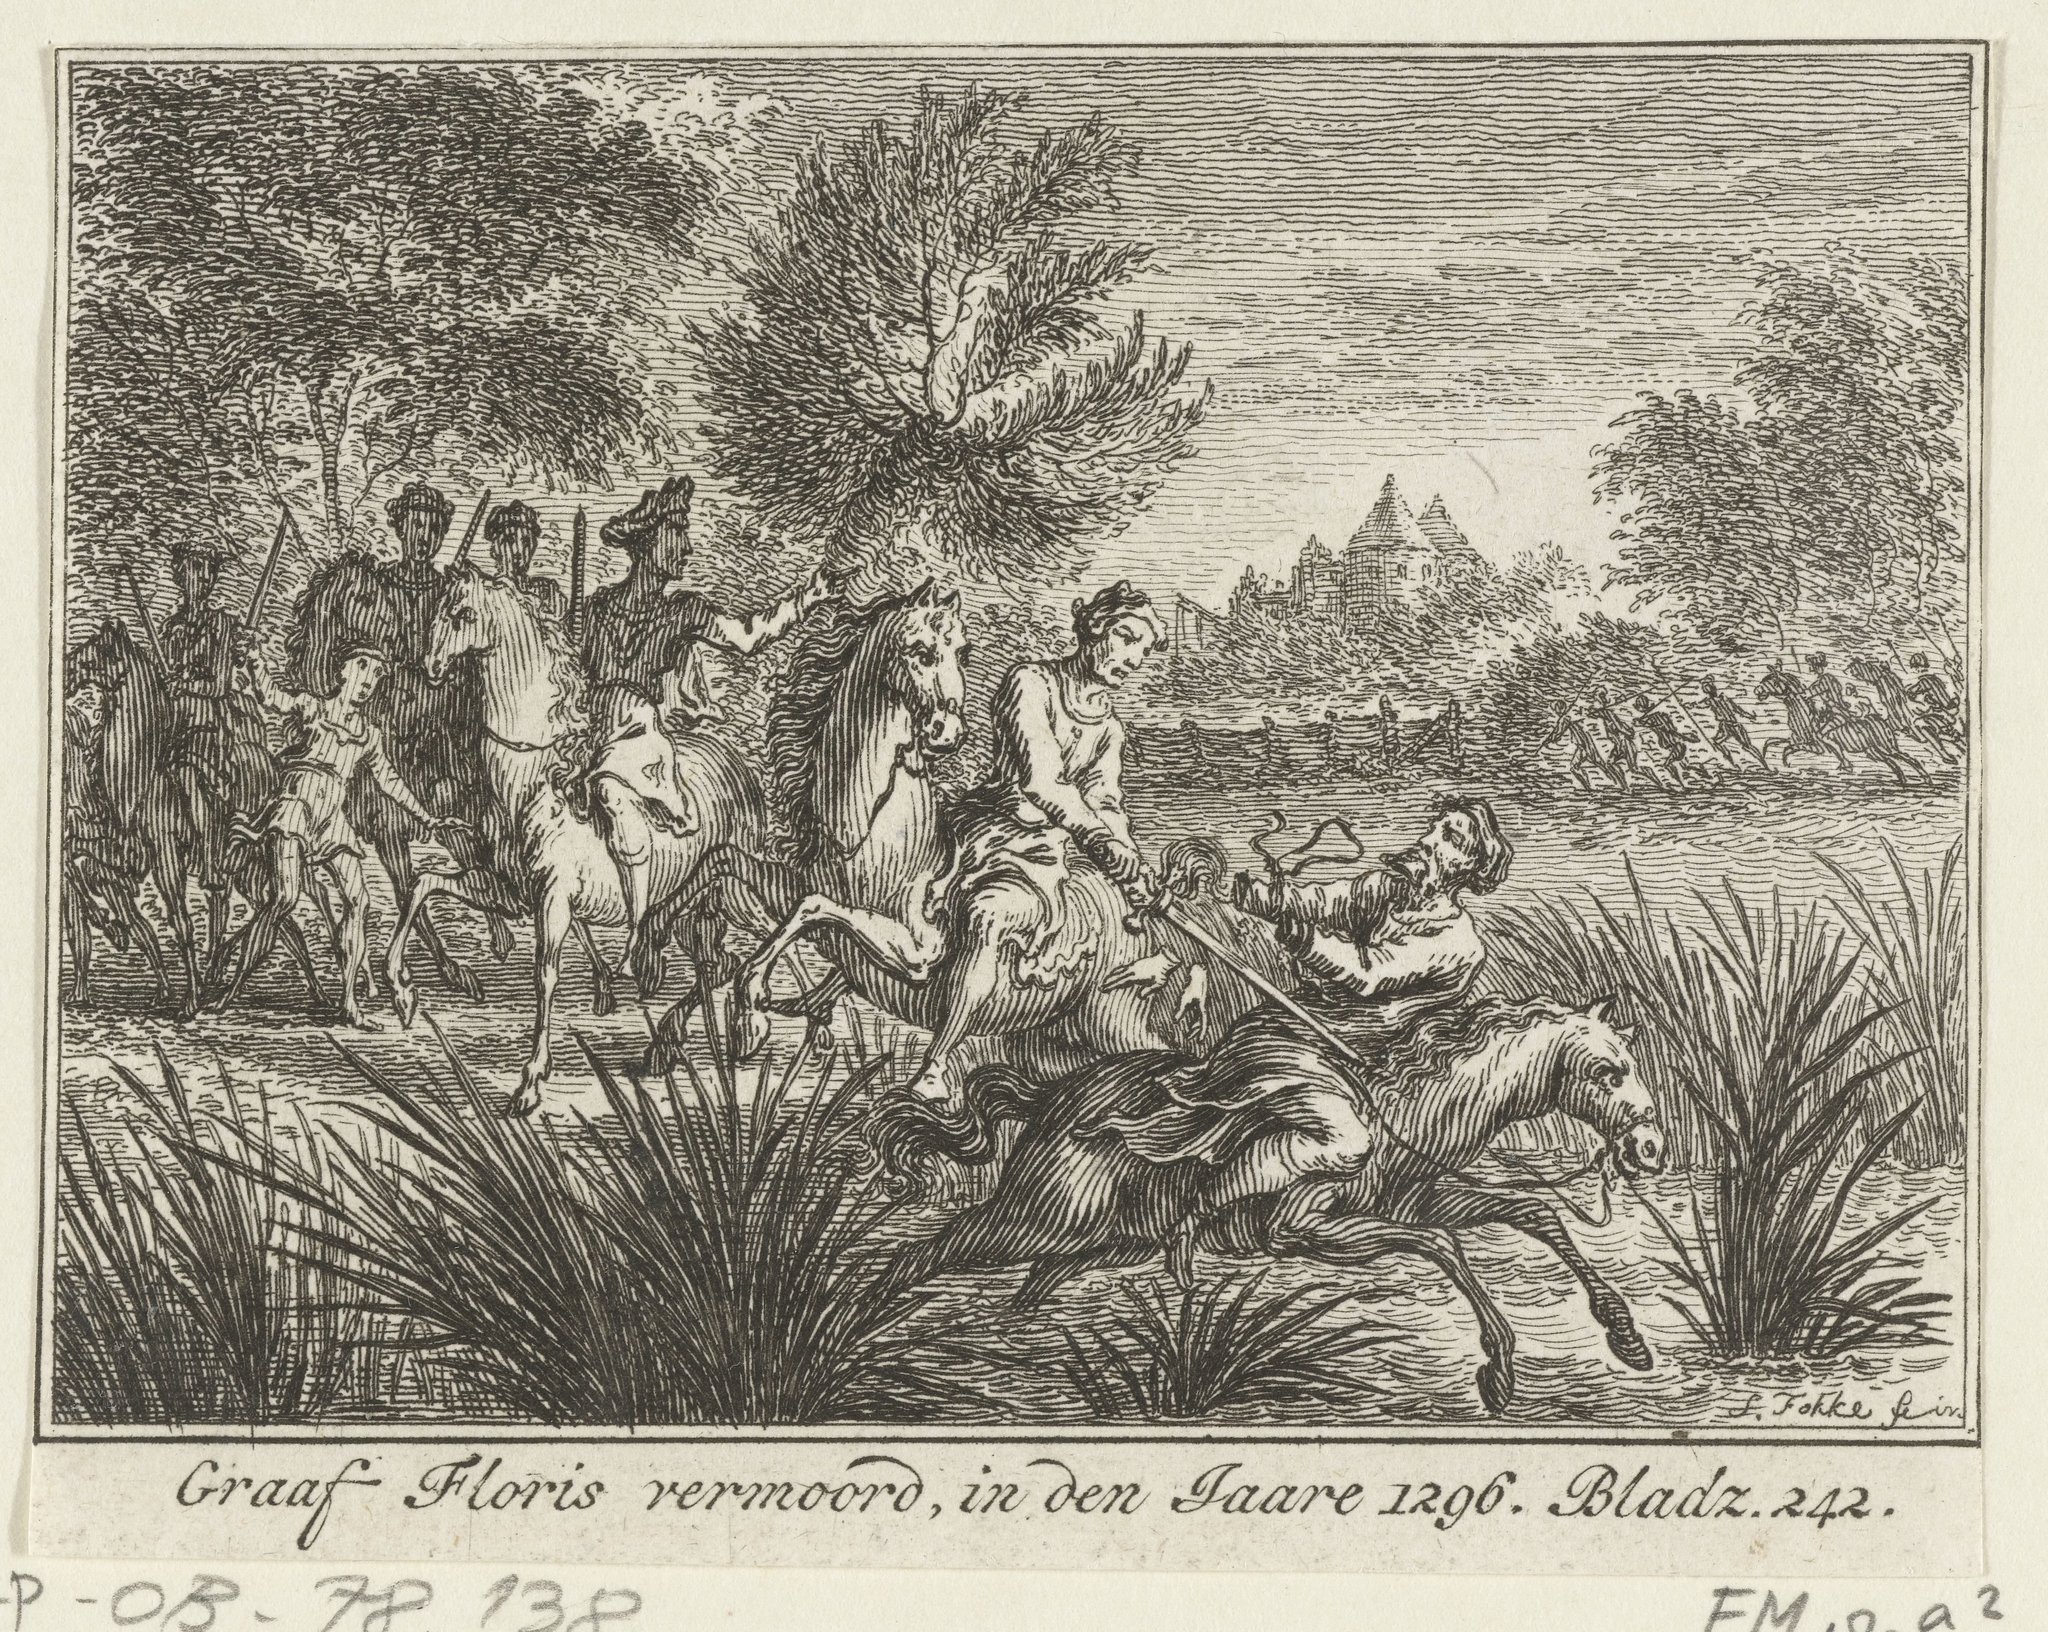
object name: print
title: Graaf Floris vermoord, in den Jaare 1296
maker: simon fokke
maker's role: draughtsman, print maker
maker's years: 1712-1784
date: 1782-1784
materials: paper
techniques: etching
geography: northern netherlands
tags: floris v (graaf van holland en zeeland), violent death, being killed; being mishandled and maltreated; seeking death, netherlands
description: Illustratie voor: J.W. te Water, De vaderlandsche Historie van den heere J. Wagenaar, verkort, en met leerzaame aanmerkingen, ten dienste der Nederlandsche jeugd, 1784-1800, 4 delen, blz. 242. Staat met de letter.